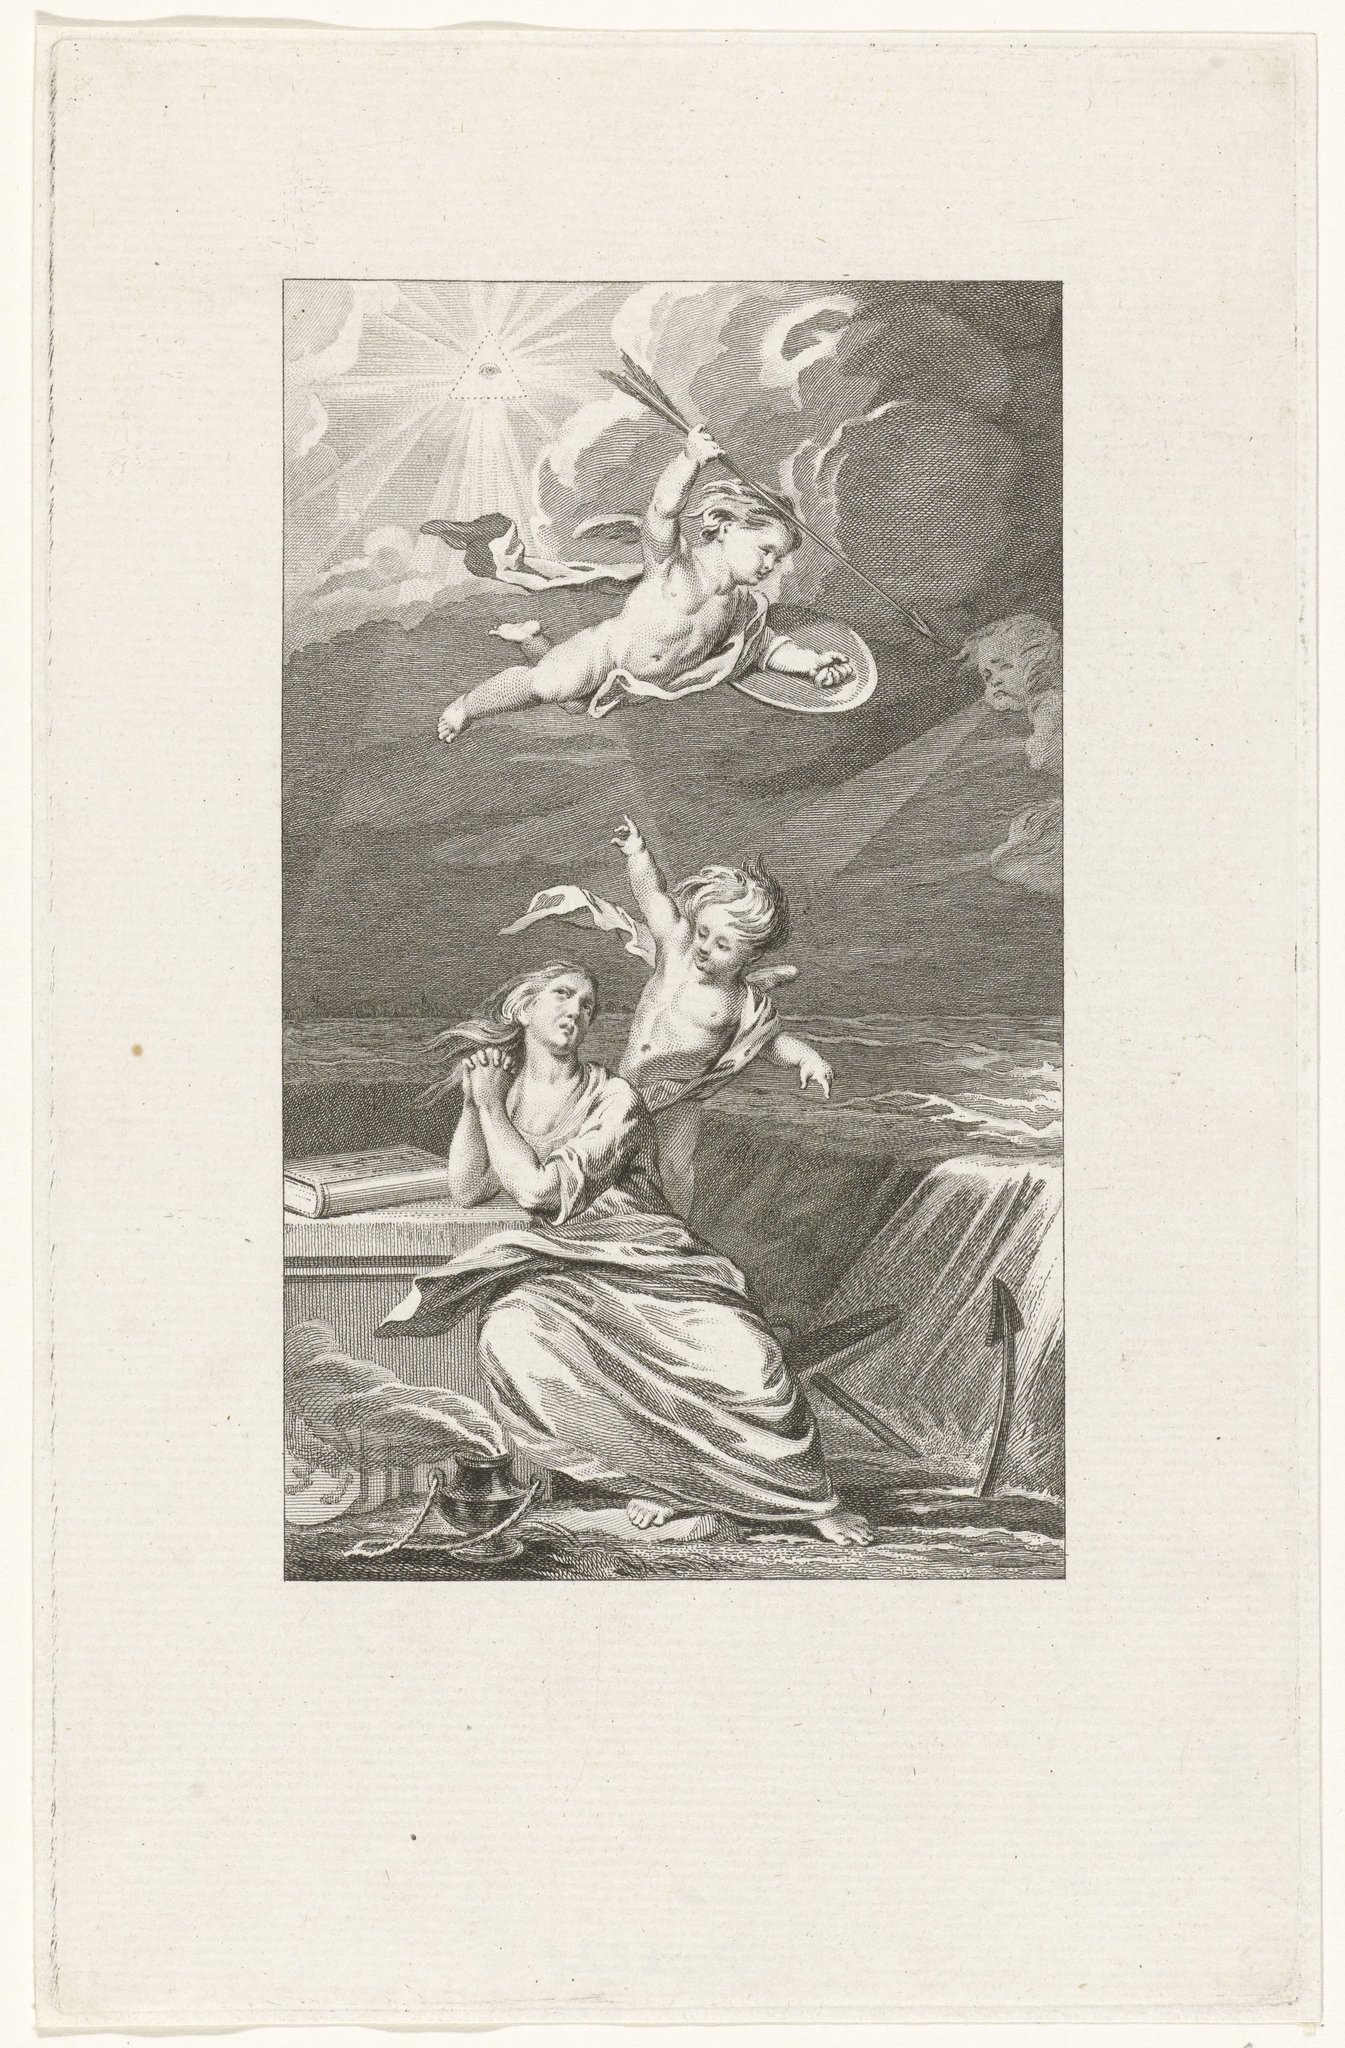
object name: print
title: Allegorie op watersnood van 1775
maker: reinier vinkeles (i)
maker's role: draughtsman, print maker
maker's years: 1741-1816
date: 1778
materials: paper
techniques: engraving, etching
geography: northern netherlands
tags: dike-break, god's wrath (+ angels floating in the air), personifications of countries, nations, states, districts, etc., the all-seeing eye, triangle with eye ~ symbol of god the father, netherlands, the flood of 14-18 november 1775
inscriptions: collector's mark: Lugt 2228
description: Allegorische voorstelling van de watersnood van 14-18 november 1775 als straf van God. De Nederlandse maagd met bijbel en anker bidt bij doorgebroken dijk tot God. In de wolken engeltjes en het Alziende Oog. Onderaan verwijzing naar: Bladz. 64.